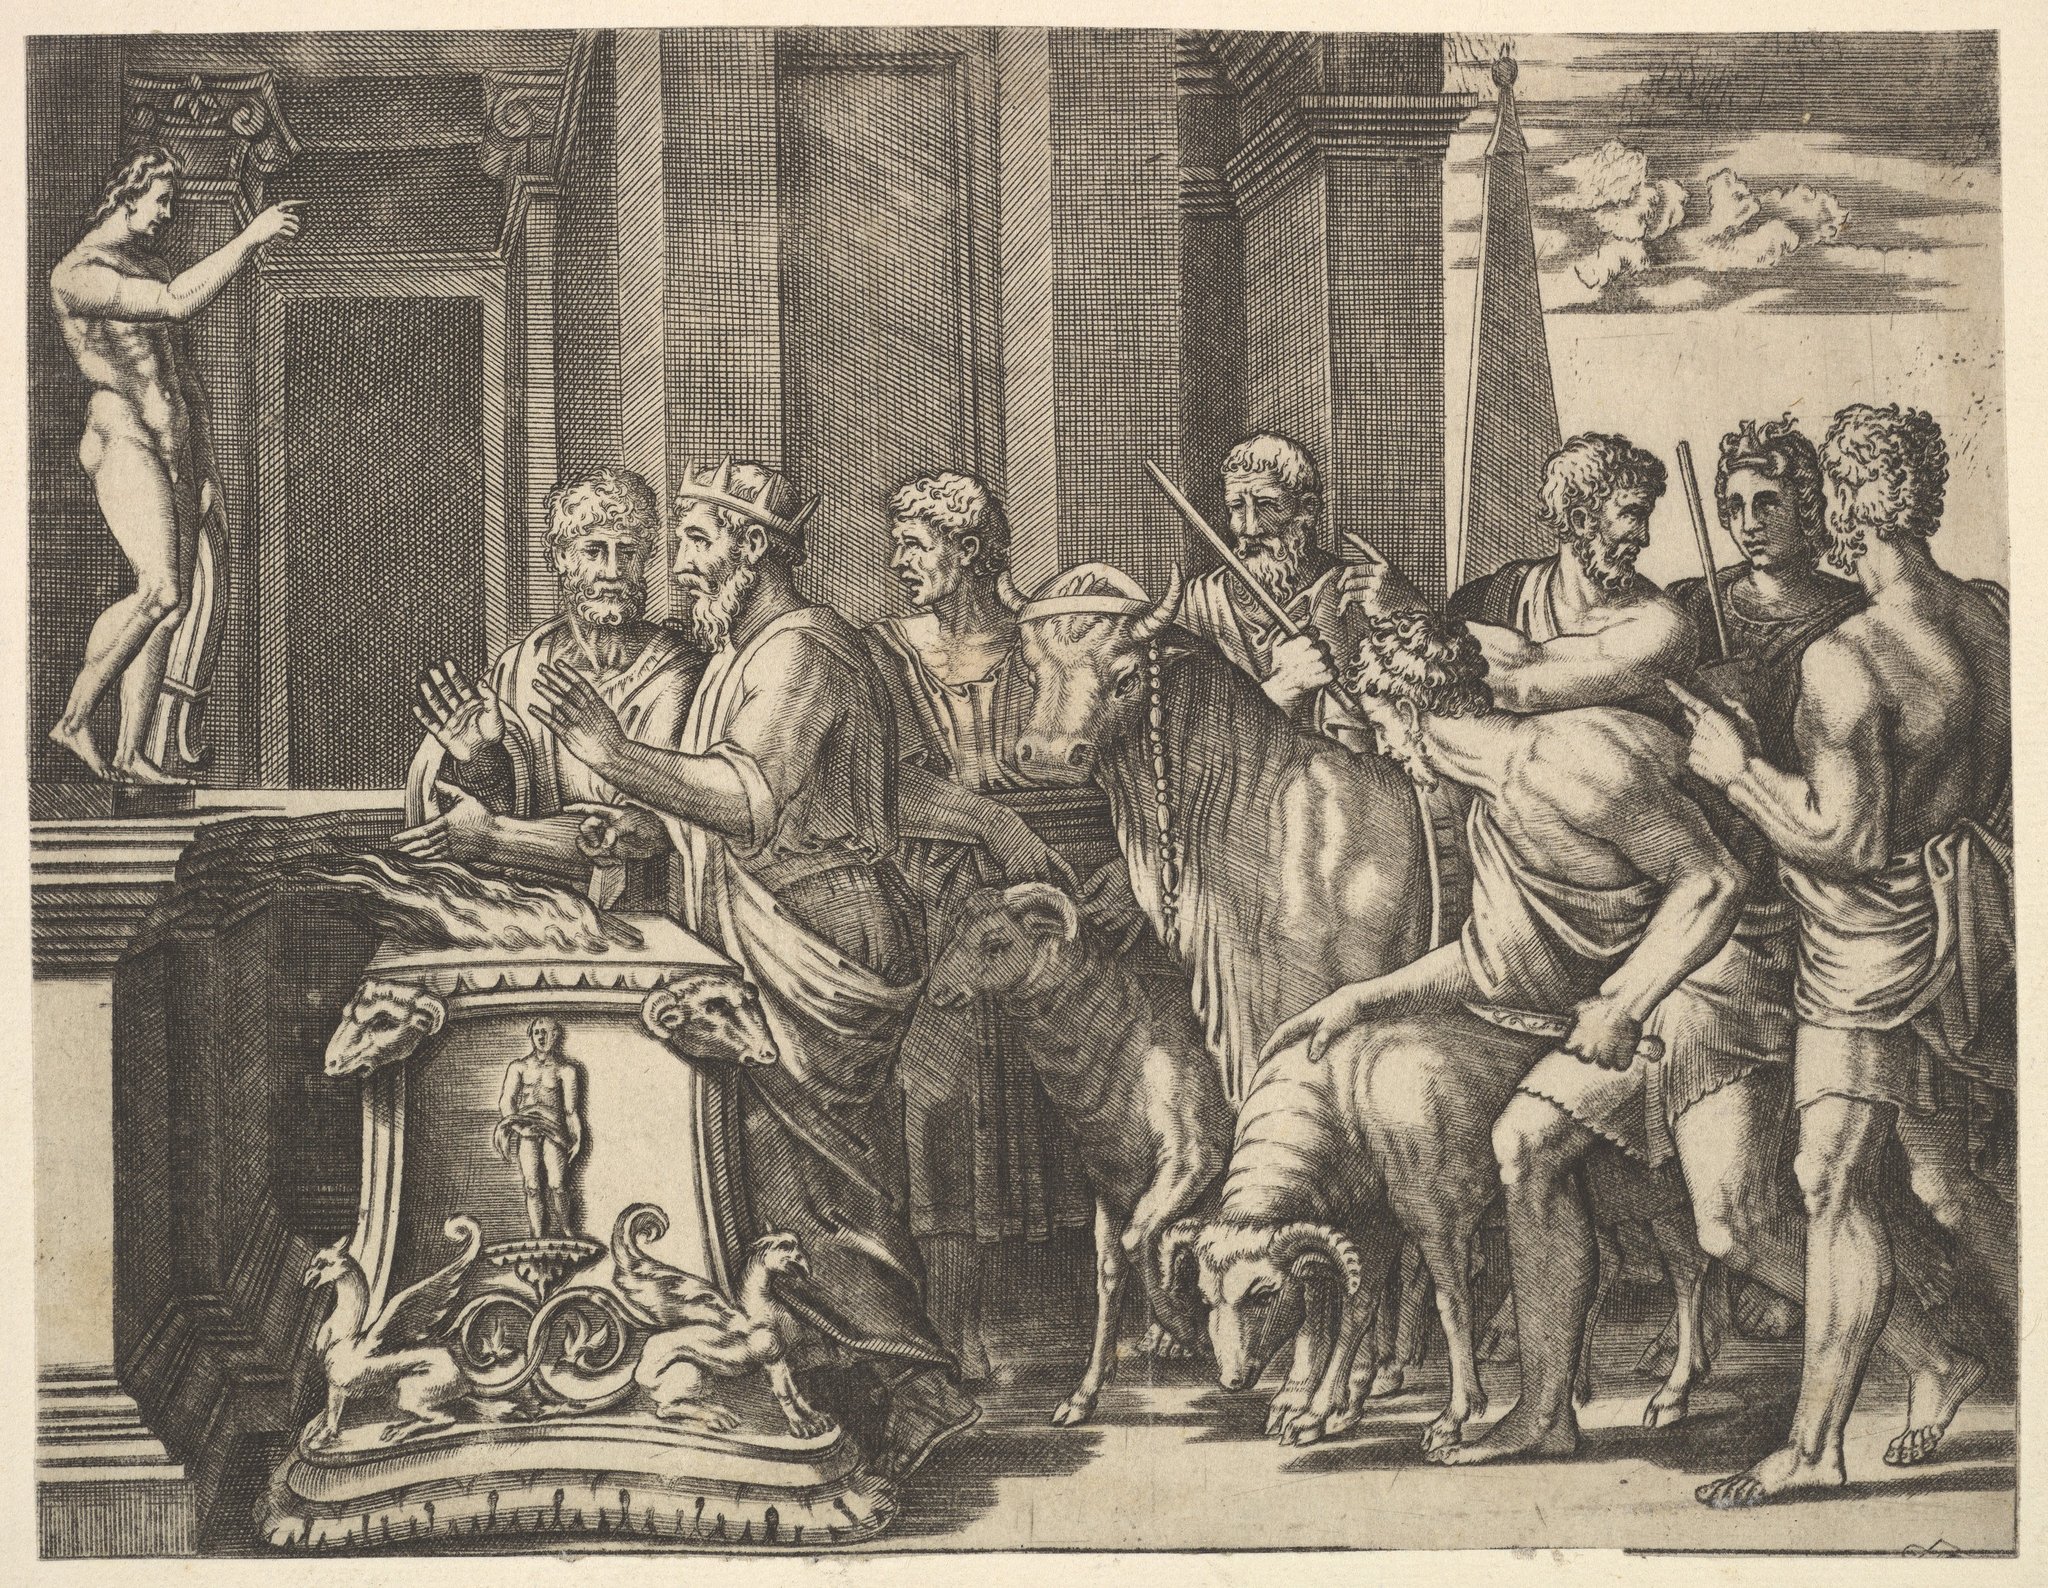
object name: print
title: Psyche's father consulting the oracle, from 'The Fable of Psyche'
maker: master of the die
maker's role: artist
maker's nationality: italian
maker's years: 1525-1560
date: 1530-1560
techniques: engraving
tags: men,cows,rams